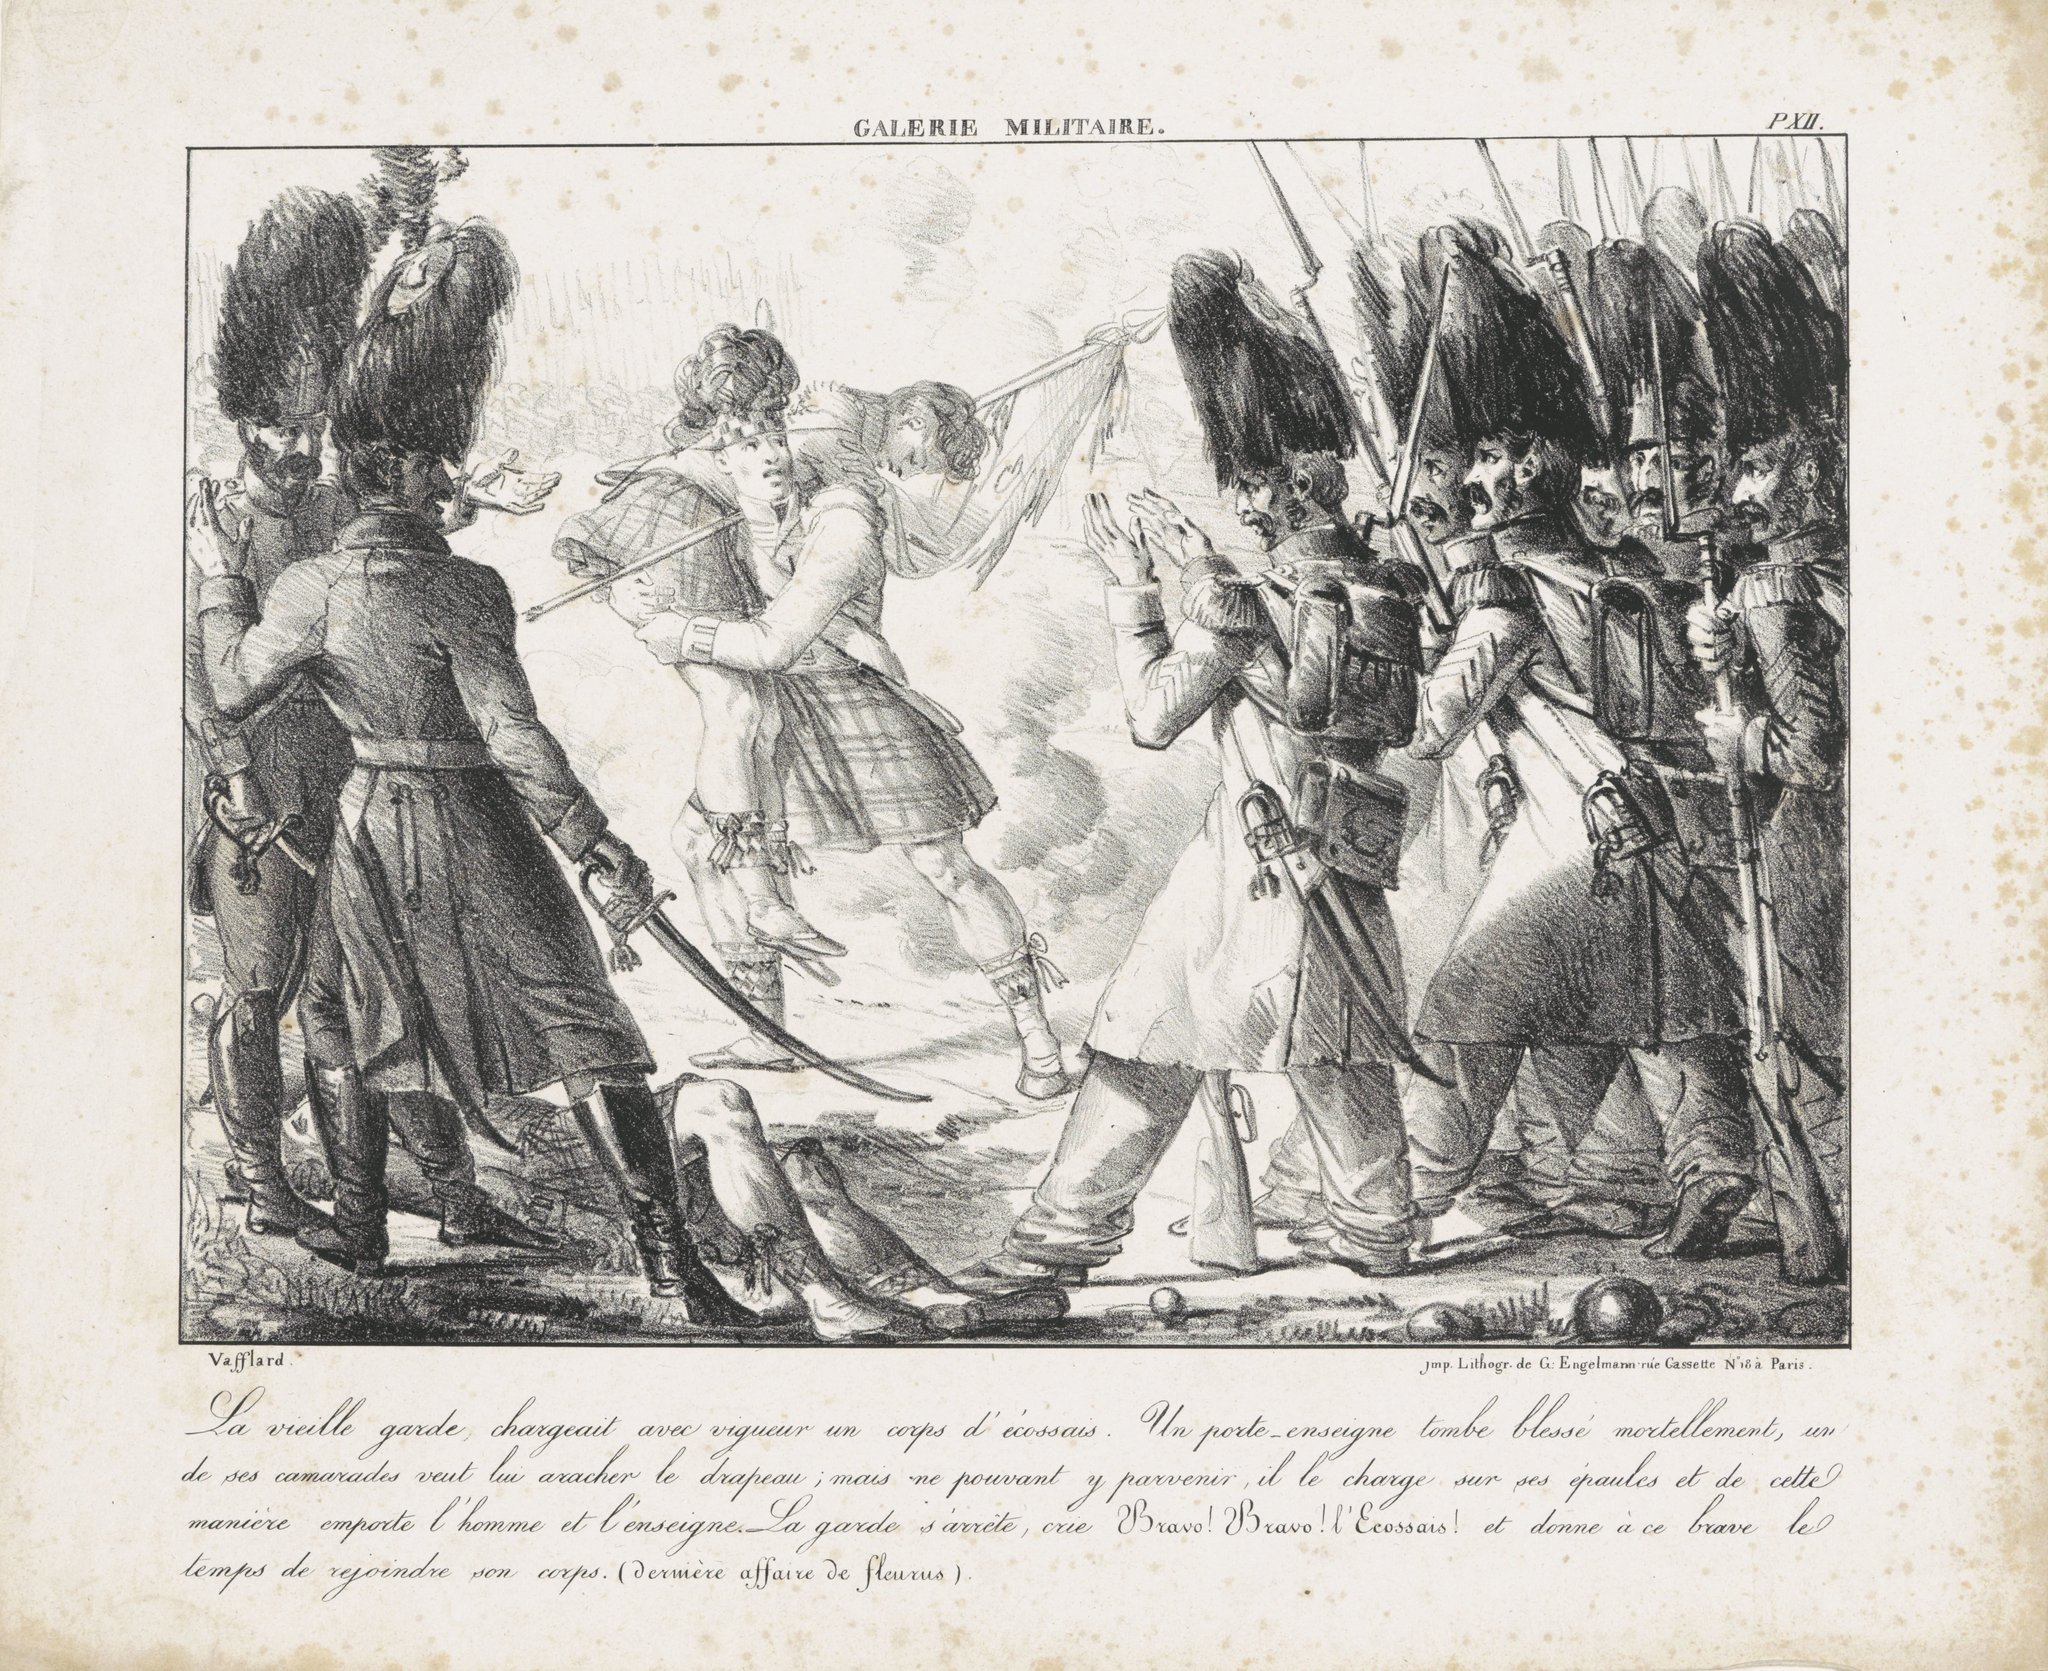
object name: print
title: Afvoer van een gewonde Schotse vaandeldrager, 1794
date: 1816-1820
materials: paper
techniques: lithograph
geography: paris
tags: battle (+ land forces)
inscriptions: collector's mark: Lugt 2228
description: Tijdens de slag bij Fleurus op 26 juni 1794 applaudiseren Franse troepen en roepen 'Bravo!' wanneer het lichaam van een dodelijk gewonde Schotse vaandeldrager door een landgenoot wordt weggedragen. Met onderschrift van vier regels in het Frans.